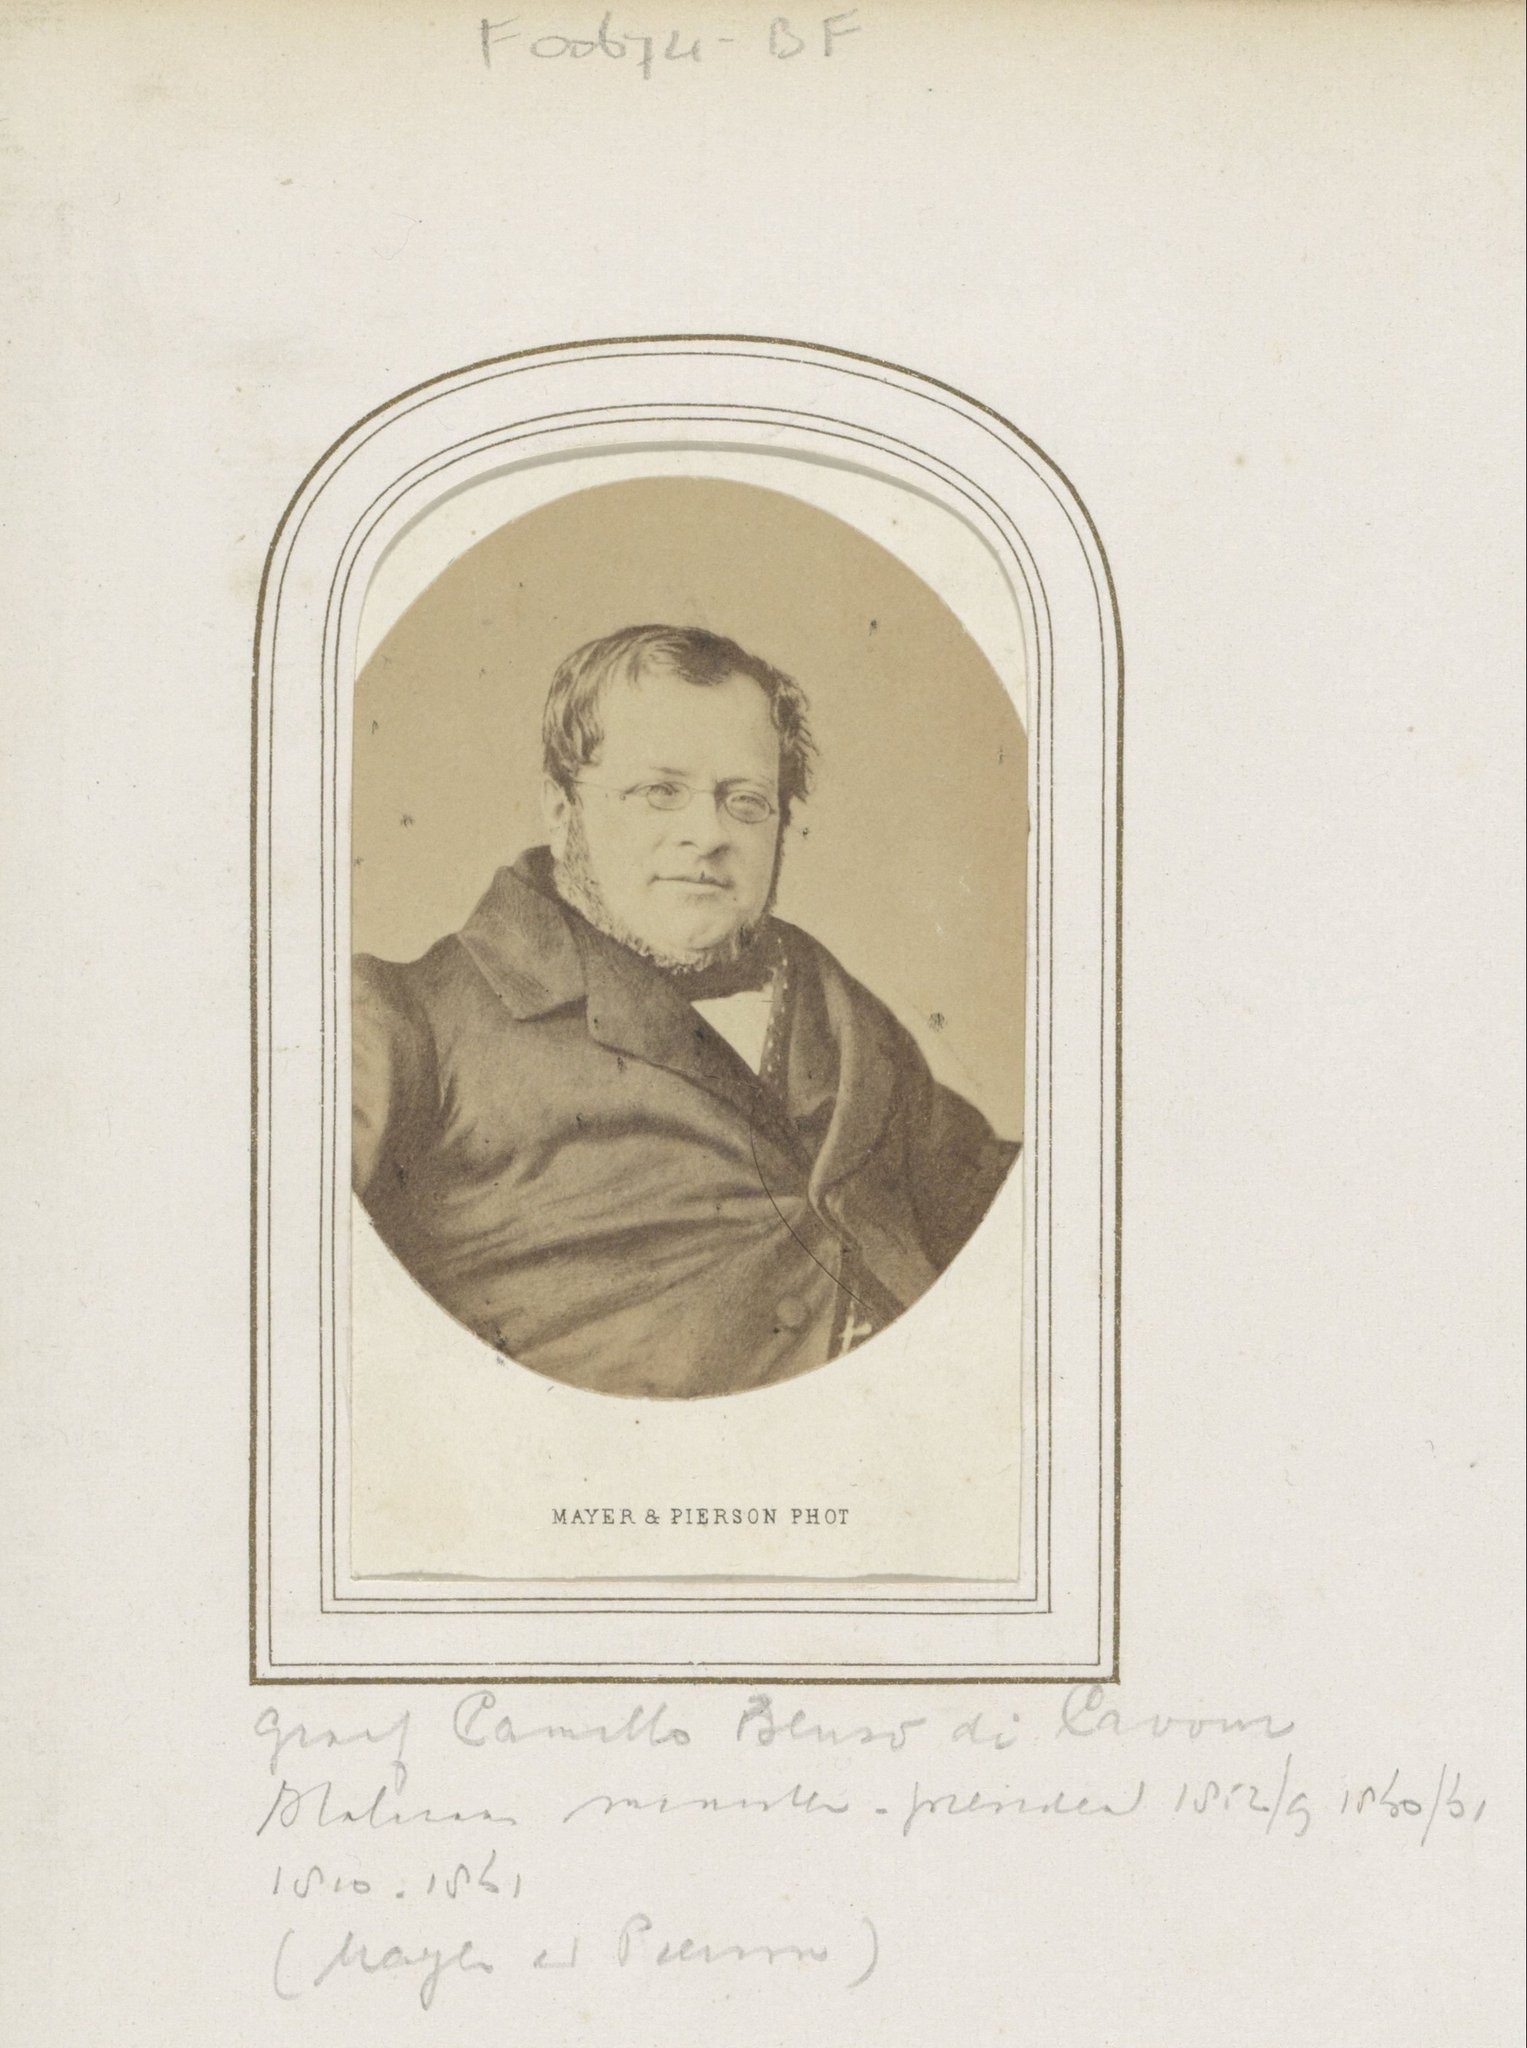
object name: carte de visite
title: Portret van graaf Camillo Benzo di Cavour, Italiaans minister-president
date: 1855-1861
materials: cardboard, paper, photographic support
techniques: albumen print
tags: politician, eyeglasses, spectacles, prime minister, historical persons, neck-gear ~ clothing, clothing for the upper part of the body, beard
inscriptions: inscription: ‘Cavour’, address: ‘Boulevart des Capucines 3, Paris’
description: Onderdeel van Fotoalbum met 123 cartes-de-visite van leden van Europese vorstenhuizen, politici en bekende personen.